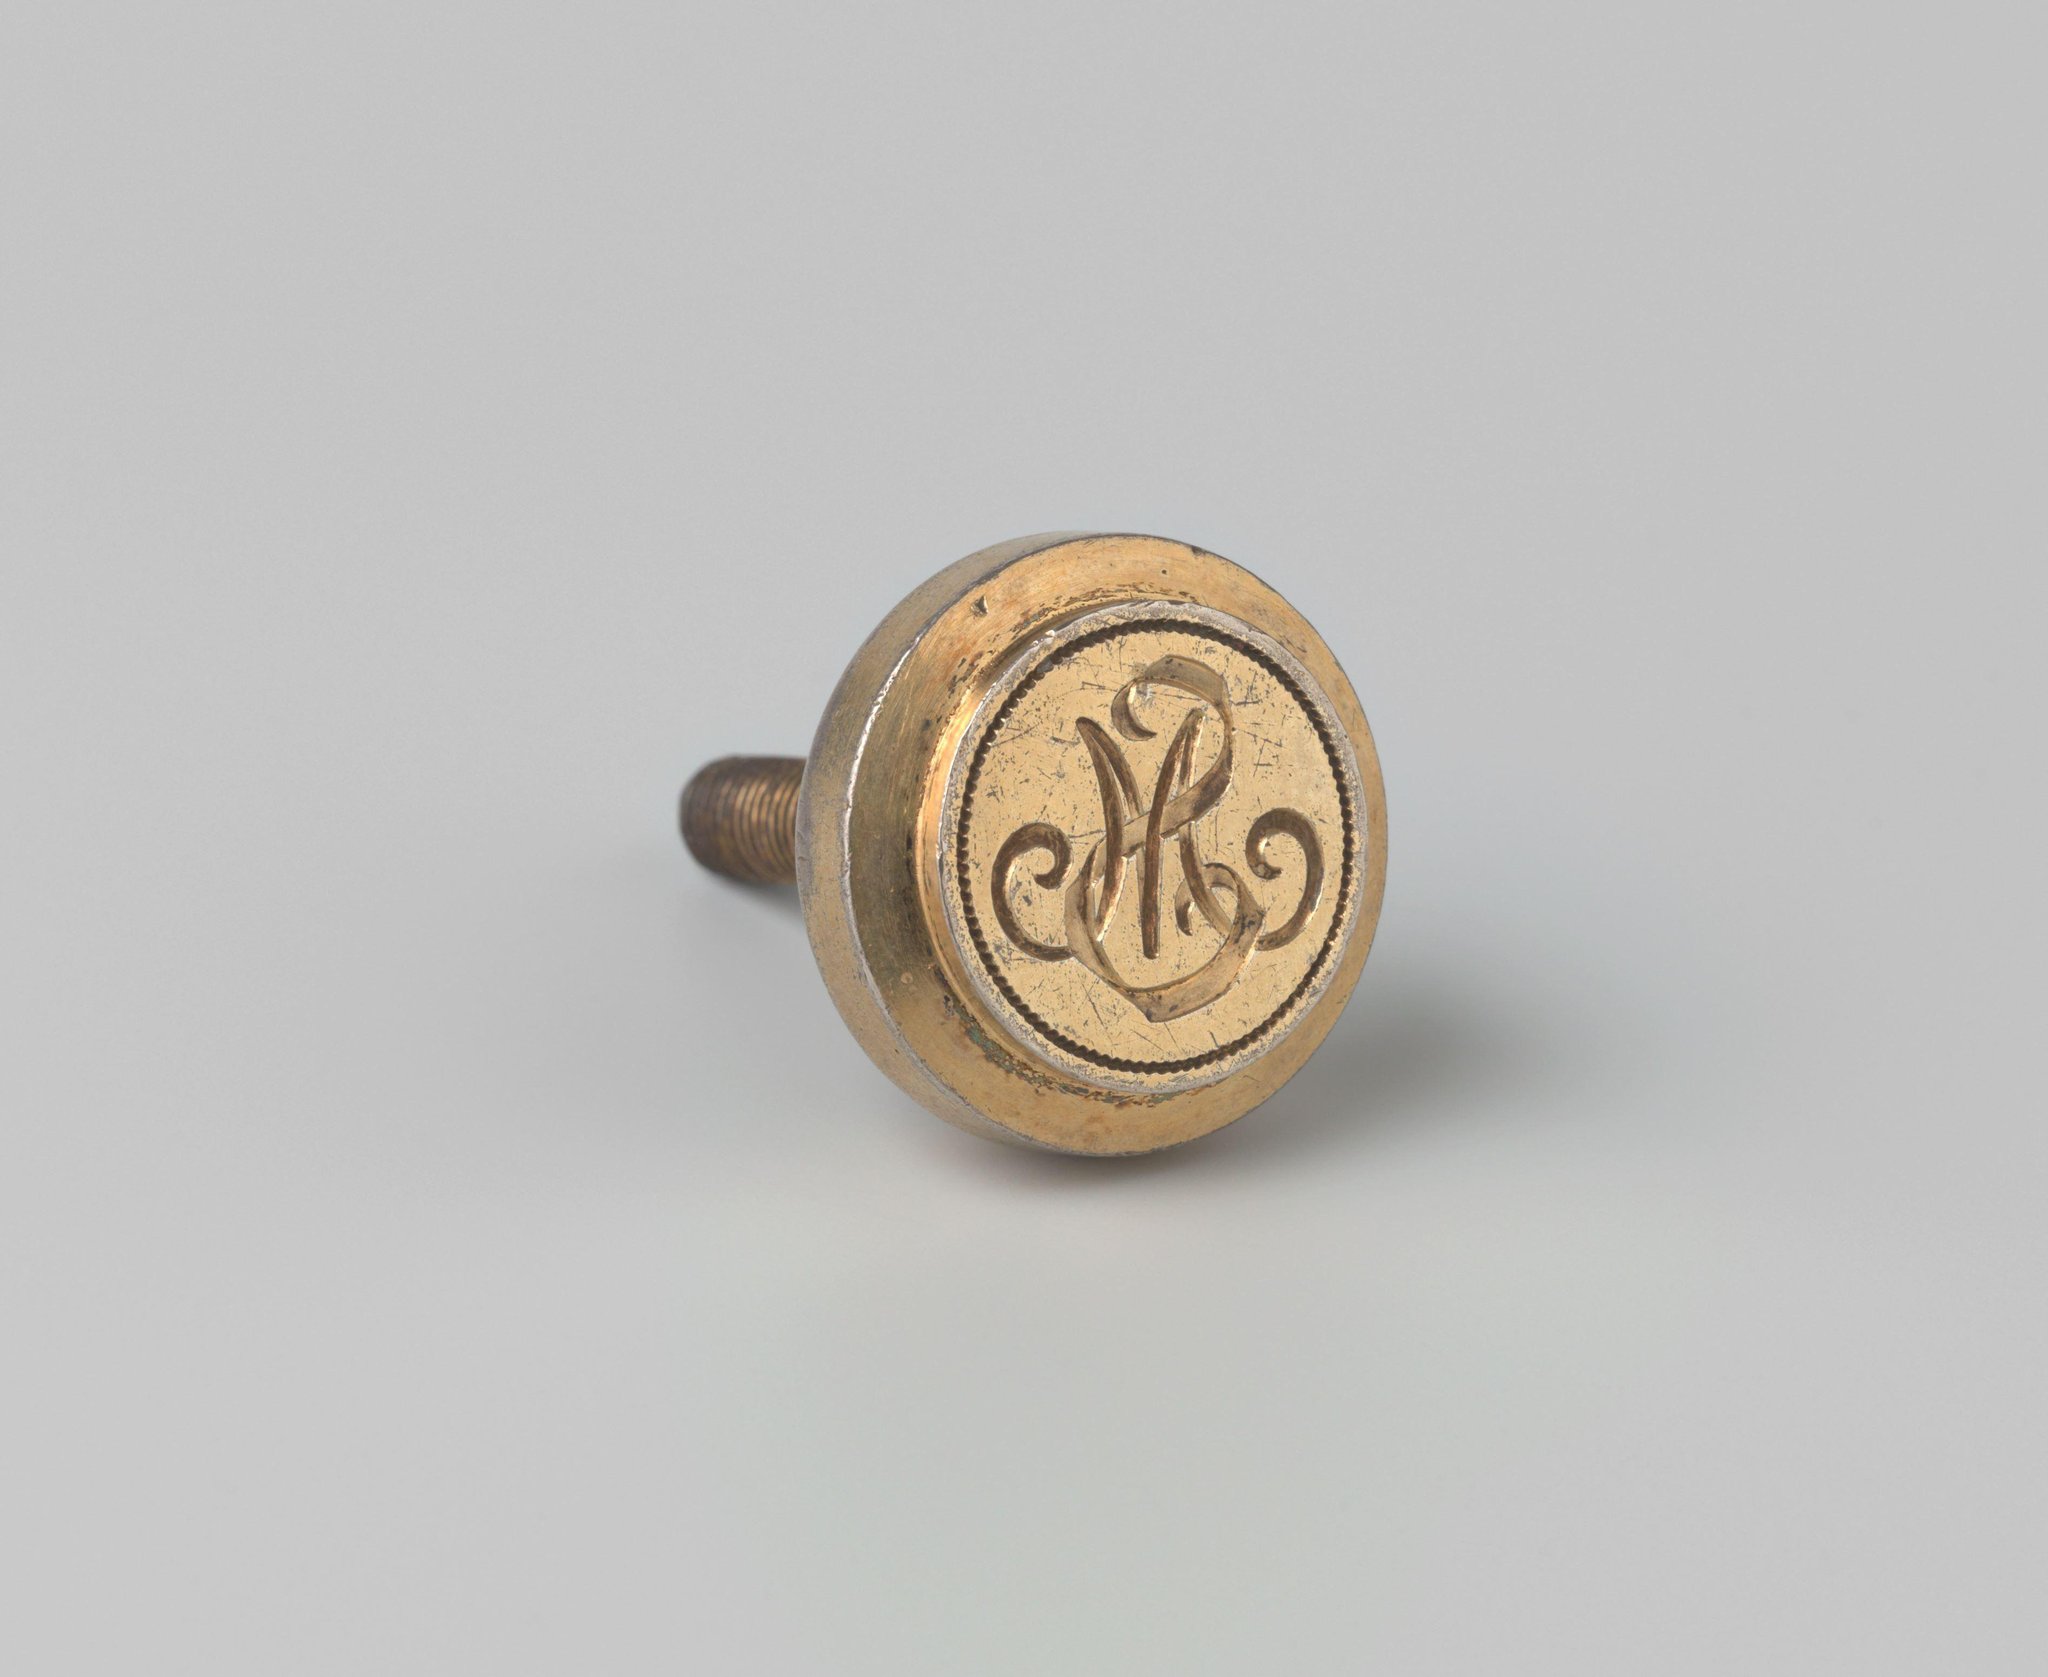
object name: zegelstempel, lakstempel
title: Walking stick handle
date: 1880-1890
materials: silver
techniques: gilding, patinaed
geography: paris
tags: snakes, rodents: rat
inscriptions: maker's mark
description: Latere toevoeging bij wandelstokknop BK-1989-15.